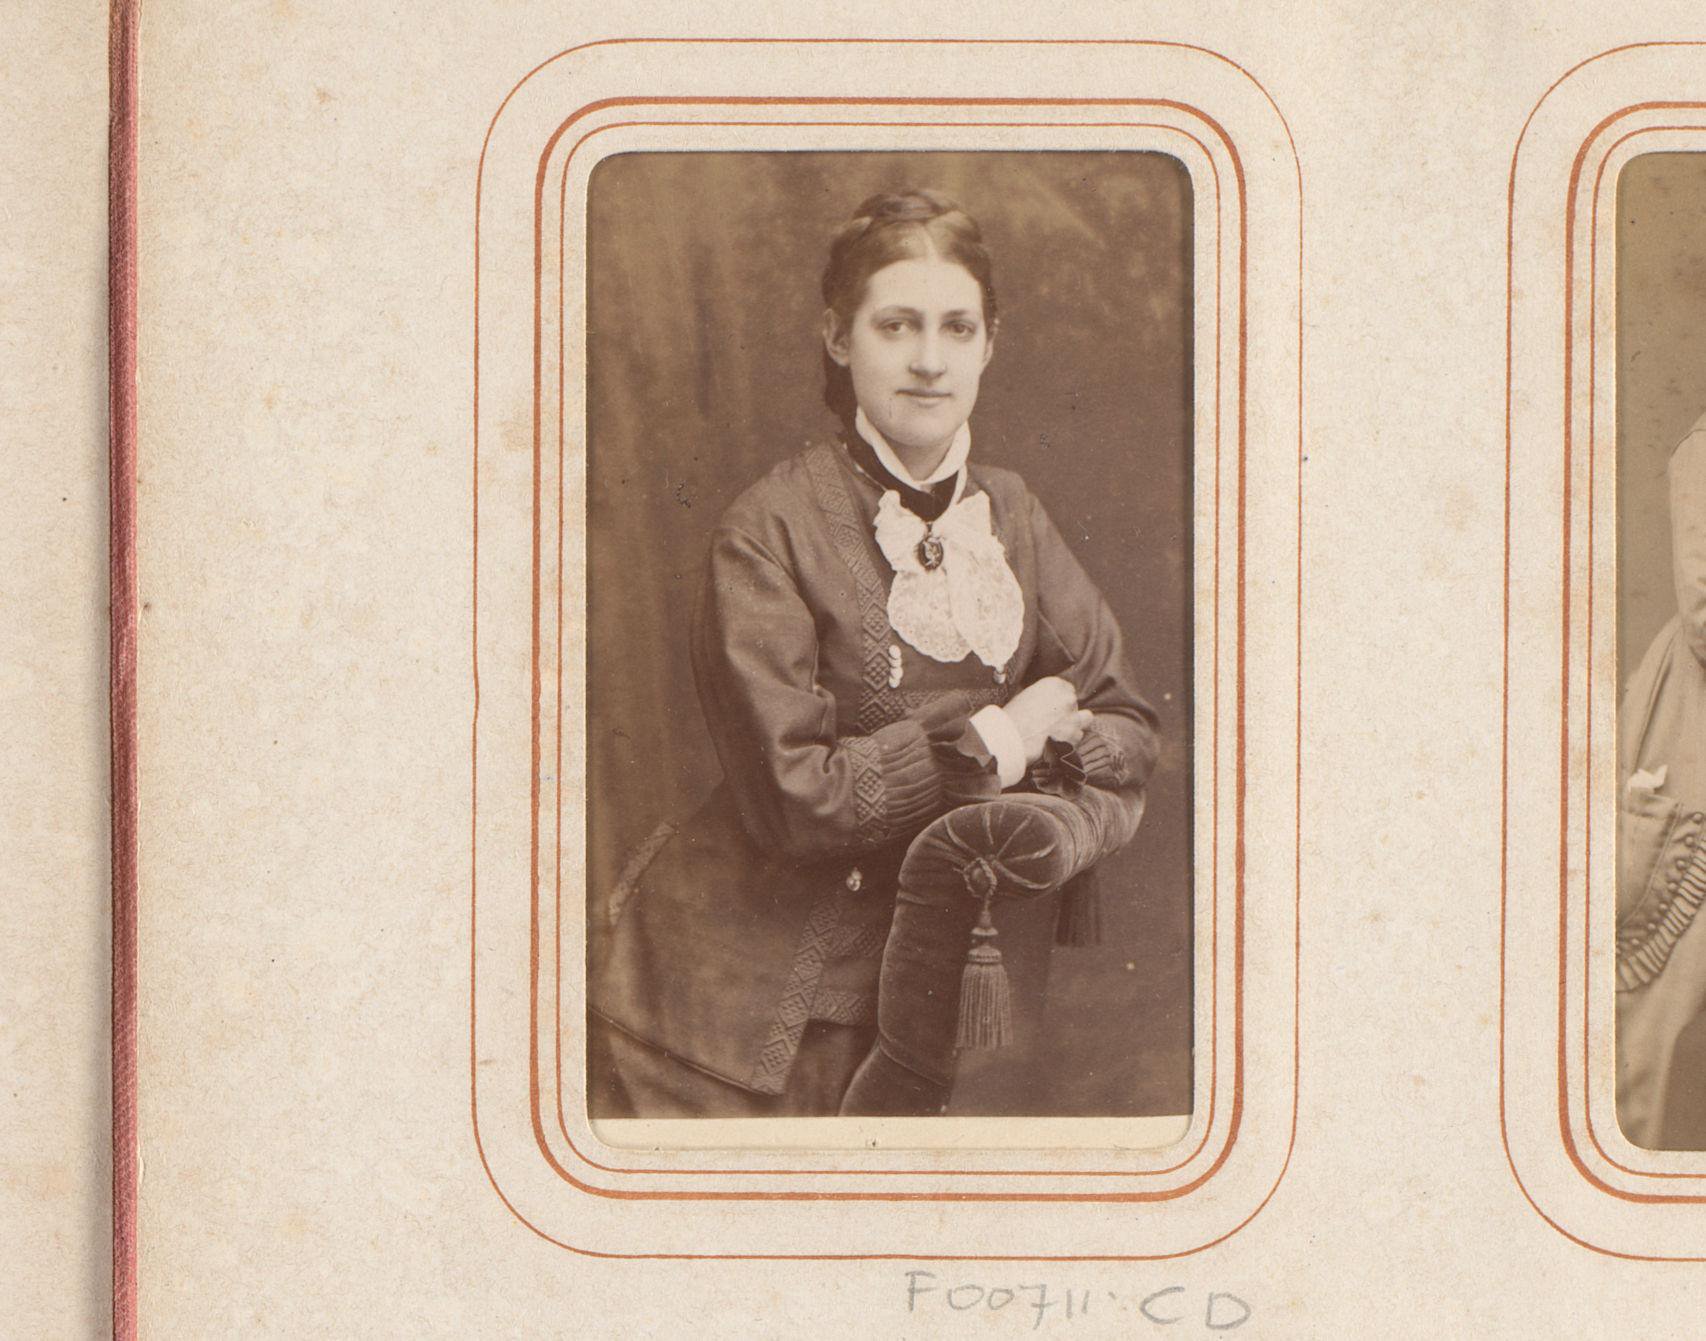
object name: photograph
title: Portret van een vrouw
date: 1865-1903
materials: cardboard, photographic support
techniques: albumen print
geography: the hague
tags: historical persons - bb - woman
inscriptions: inscription: ‘De Lavieter & Co/ Photographes/ Willemstraat No.2/ La Haye’